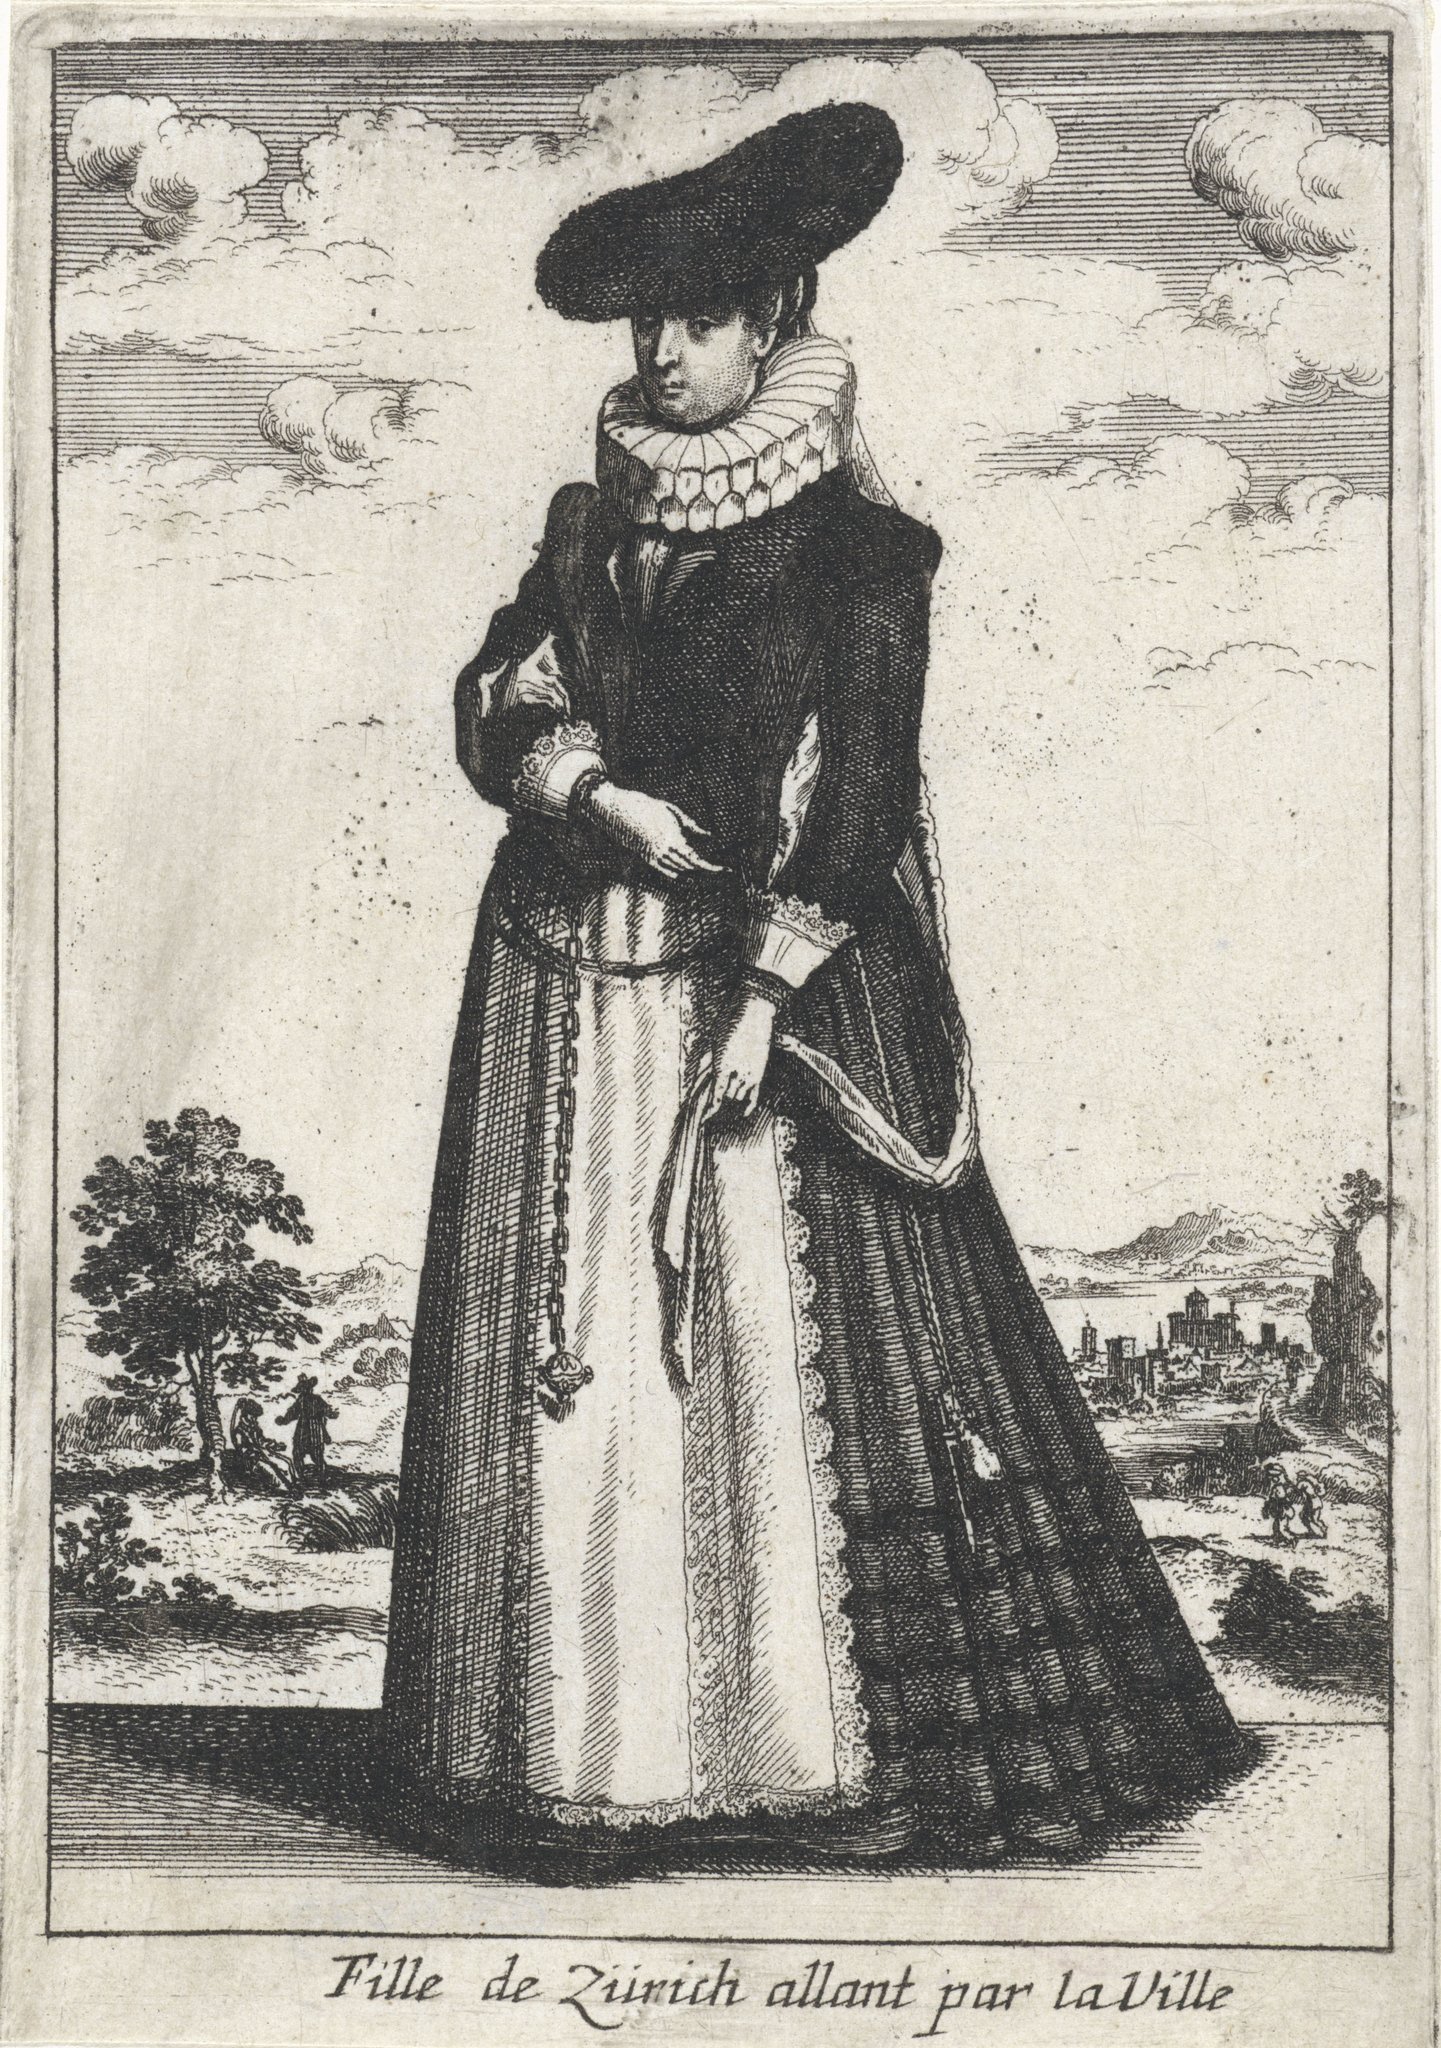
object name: costume print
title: Vrouwen in klederdracht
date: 1662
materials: paper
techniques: etching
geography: paris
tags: zürich (stad)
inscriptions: collector's mark: Lugt 240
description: Kopie naar prent die deel uitmaakt van de 50-delige serie met Europese klederdrachten, getiteld "Aula Veneris".. De prent maakt deel uit van de 28-delige serie (excl. titelprent) met voorstellingen van vrouwen in verschillende klederdrachten, getiteld "Livre curieux contenant la naifue representations des habits des femmes des diverses parties du Monde (...), 1662".